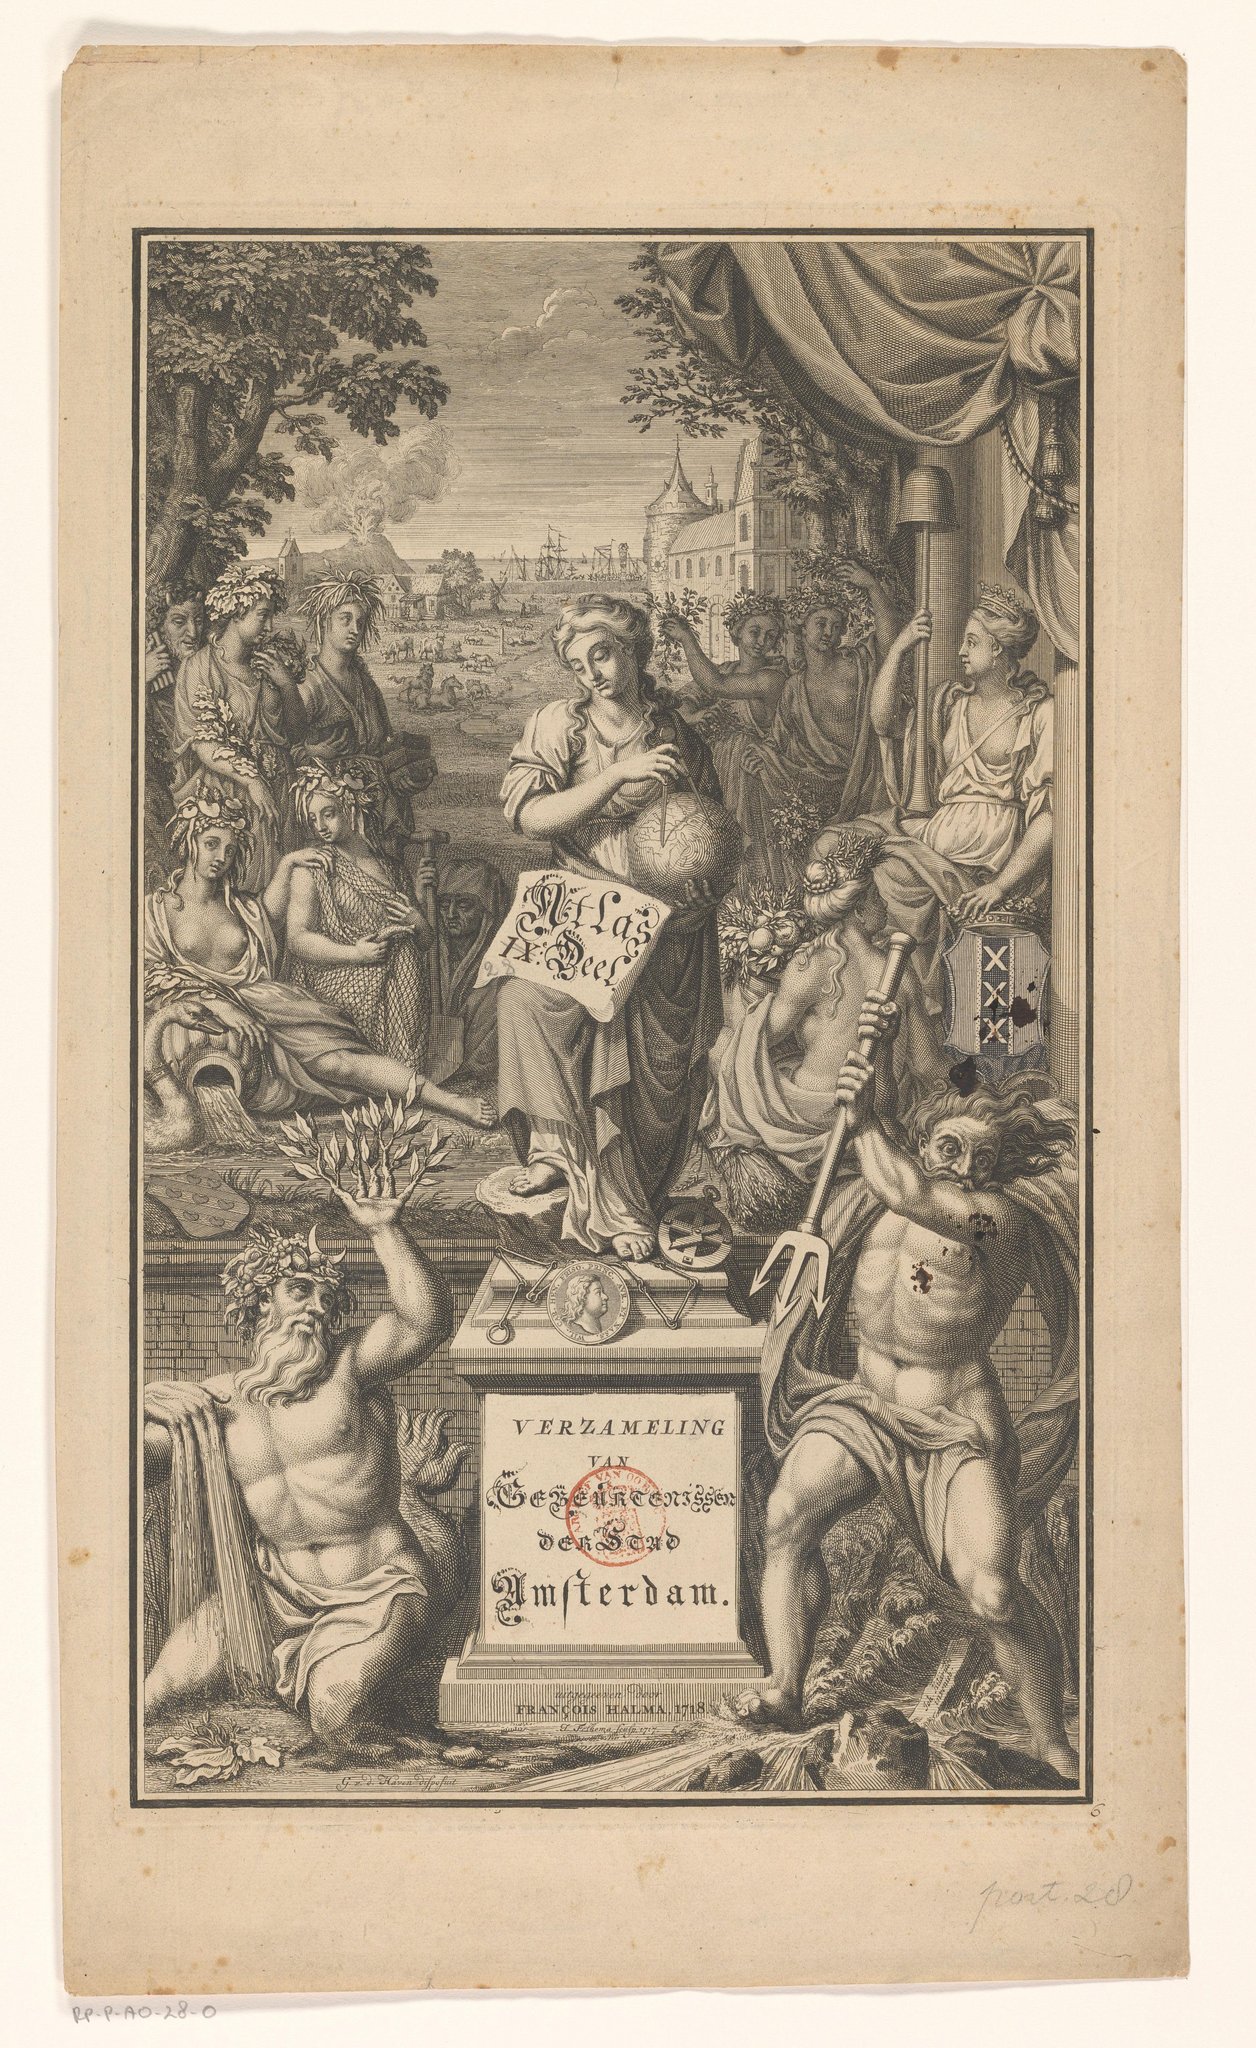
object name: titelprent, frontispice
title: Atlas IXe: [28] Deel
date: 1717-1718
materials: ink, paper, pencil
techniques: engraving, etching, pen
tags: commercial fishery, (story of) ceres (demeter), coat of arms (as symbol of the state, etc.) (+ city; municipal), peat-cutting, 'astronomia', 'cosmografia'; 'cosmografia' (ripa), personifications of countries, nations, states, districts, etc., river-gods, 'corografia', 'geografia', 'hidrografia' (ripa), agriculture, fruitfulness, productiveness, fertility, fecundity; 'fecondità' (ripa), (story of) flora, neptune as lord of the sea, amsterdam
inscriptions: collector's mark: Lugt 19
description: Deze prent is hier gebruikt als titelprent van een deel van een ongebonden atlas; een verzameling cartografische en topografische prenten en tekeningen. Oorspronkelijk was de prent echter bedoeld als titelpagina voor een gebonden atlas met kaarten van Friesland, waardoor een deel van de hier volgende beschrijving betrekking heeft op die context. Op het voetstuk in het midden staat de personificatie van de cartografie, met in haar hand een aardbol die ze met een passer meet. Op haar bovenbeen rust een blad met het handgeschreven deel van de atlas (oorspronkelijk een kaart van Friesland). Aan haar voeten een meetketting, een rond (land)meetkundig instrument en een portret van Willem IV van Oranje-Nassau. Daaronder de handgeschreven titel van dit deel van de atlas. Ze houdt een wakend oog op Wispelturigheid (Wispeltuer), linksonder. Oorspronkelijk staat hij voor de wispelturigheid waar het Friese land zich naar moest schikken: een bos kon opeens onder water staan, want zijn lichaam smelt door het zoute water van de zee. Linksboven zijn hoofd een wapenschild met het wapen van Friesland (met schuinbalken en pompeblêden). De dreiging van de zee is rechtsonder verbeeld door een onstuimige Neptunus (Zeevoogd). Links en rechts van Cartografie nog meer figuren die oorspronkelijk betrekking hadden op Friesland en haar vruchtbare natuur, visserij en landbouw. Links, met haar arm leunend op een kruik waar water uitstroomt, een stroomgodin (Stroomvoogdess) met rechts van haar de personificatie van de visserij (Visschevang). Boven hen van links naar rechts: een sater met fluit als personificatie van de natuur (Natuer), de personificatie van de bossen met eikenloven (Woudman) en personificatie van de turfwinning (vrouw Veenbrand). Rechtsonder haar vrouw Onland, die rouwt om de schade die de turfwinning aan het land veroorzaakt. Rechts van Cartografie zit Flora en/of Ceres (vrouw Veldgewas) met korenaren en cornucopia, ze staat voor de overvloed die voortvloeit uit het land. Boven haar, op de achtergrond, twee vrouwelijke personificaties die in verband staan met groene weides en/of grasvelden: Beemdeheil en Graazevol. Rechts, met in haar ene hand een bazuin met daarop een vrijheidshoed en in de andere hand een schild met het wapen van Amsterdam, de personificatie van het gebied van dit deel van de atlas (oorspronkelijk de Friese Maagd met het provinciewapen met twee leeuwen). Op de achtergrond een landschap met kenmerkende Friese elementen, zoals het Sjaerdemaslot te Franeker en de vuurspuwende Rode Klif te Gaasterland (zou in de oudheid een vulkaan zijn geweest).